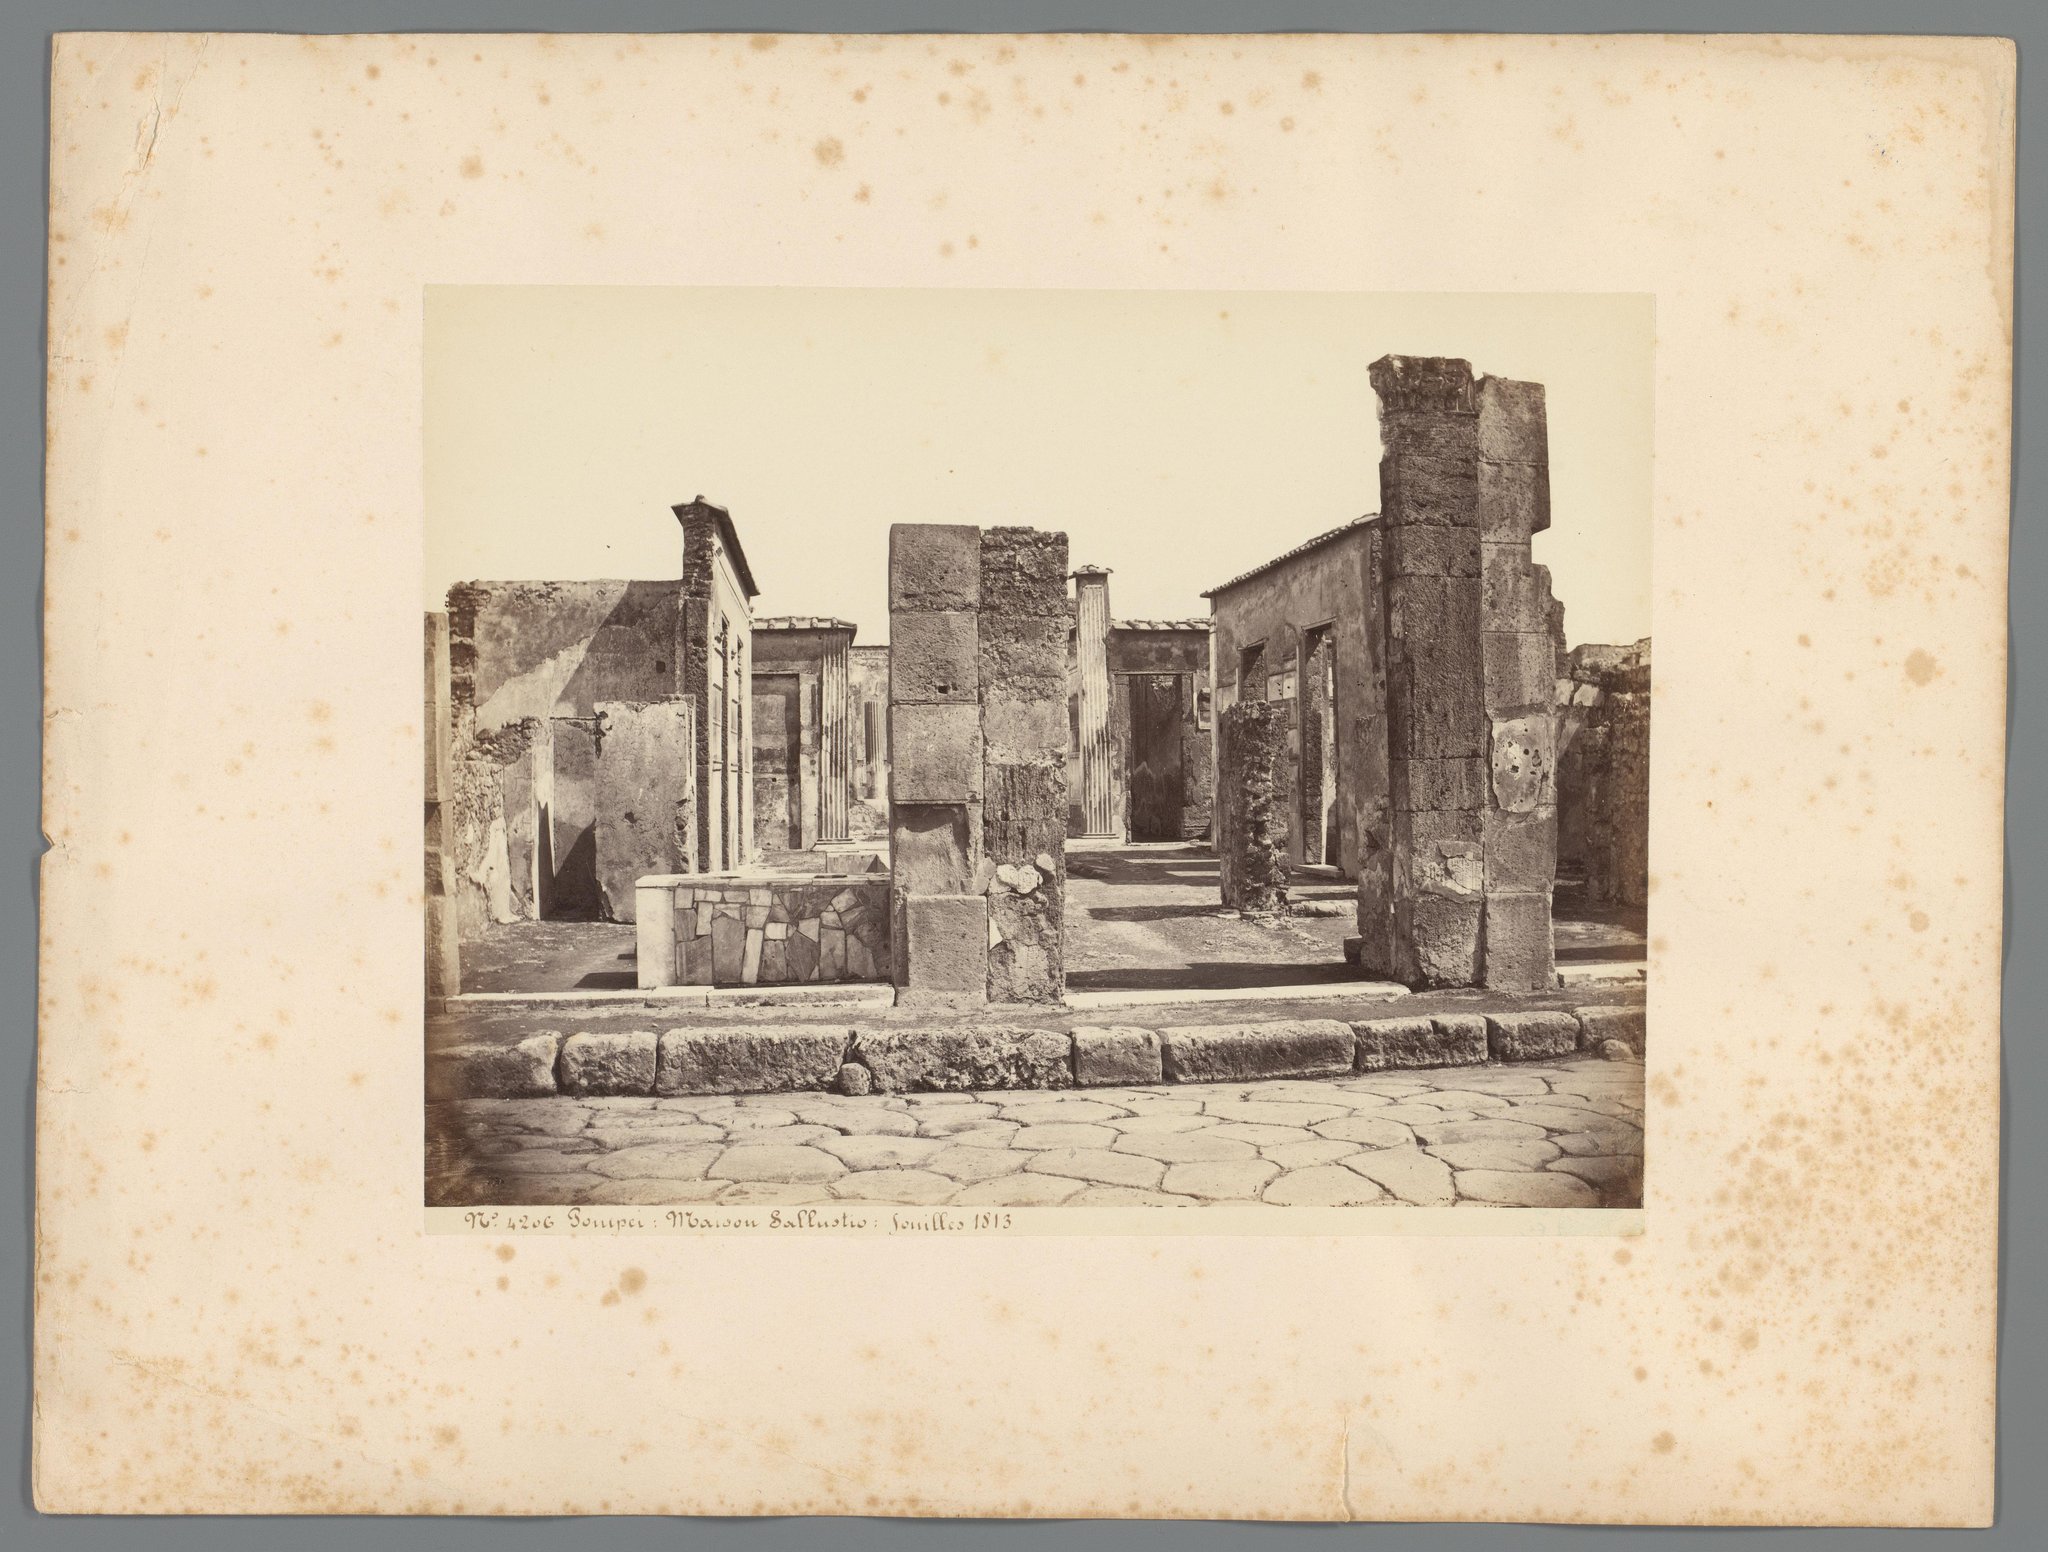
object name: photograph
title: Pompei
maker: giorgio sommer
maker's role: fotograaf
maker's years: 1834-1914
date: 1857-1875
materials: cardboard, paper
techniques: albumen print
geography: pompeii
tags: ruin of a building ~ architecture, excavation ~ archaeology, pompeii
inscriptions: number: ‘12’, number: ‘11’, inscription: ‘sz’, number: ‘No. 4206’